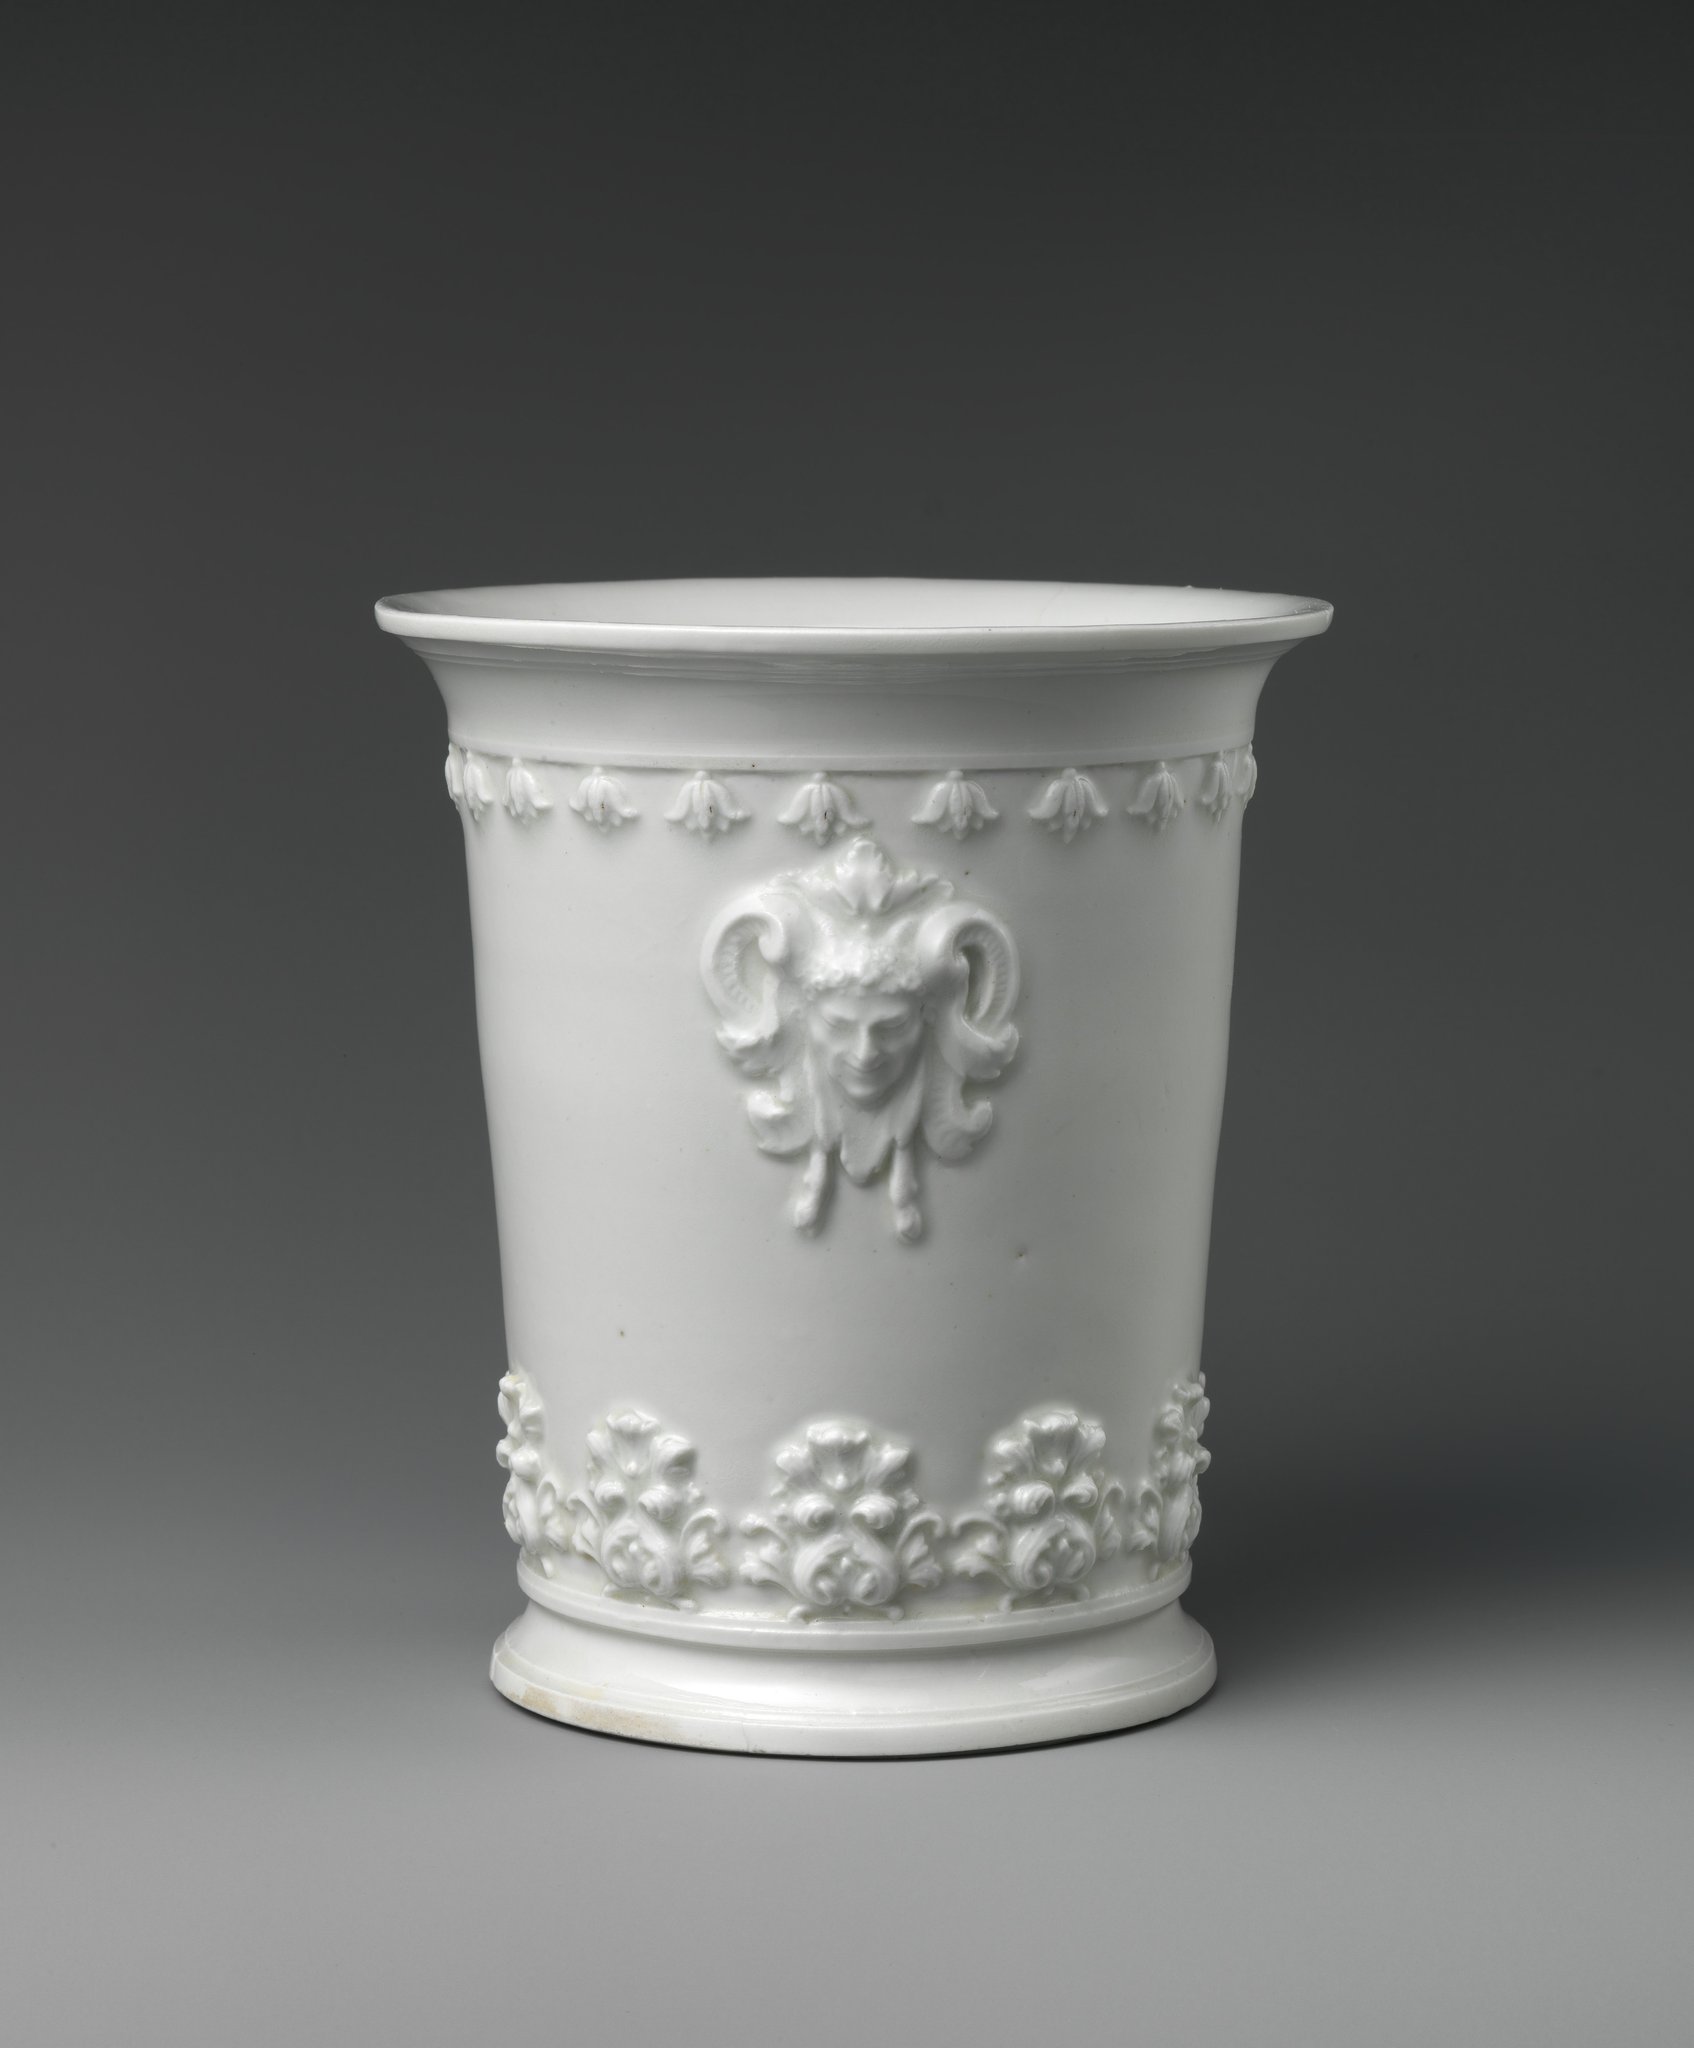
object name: vase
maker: meissen manufactory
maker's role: manufactory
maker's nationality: german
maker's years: 1710-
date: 1713-1720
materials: hard paste porcelain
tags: masks